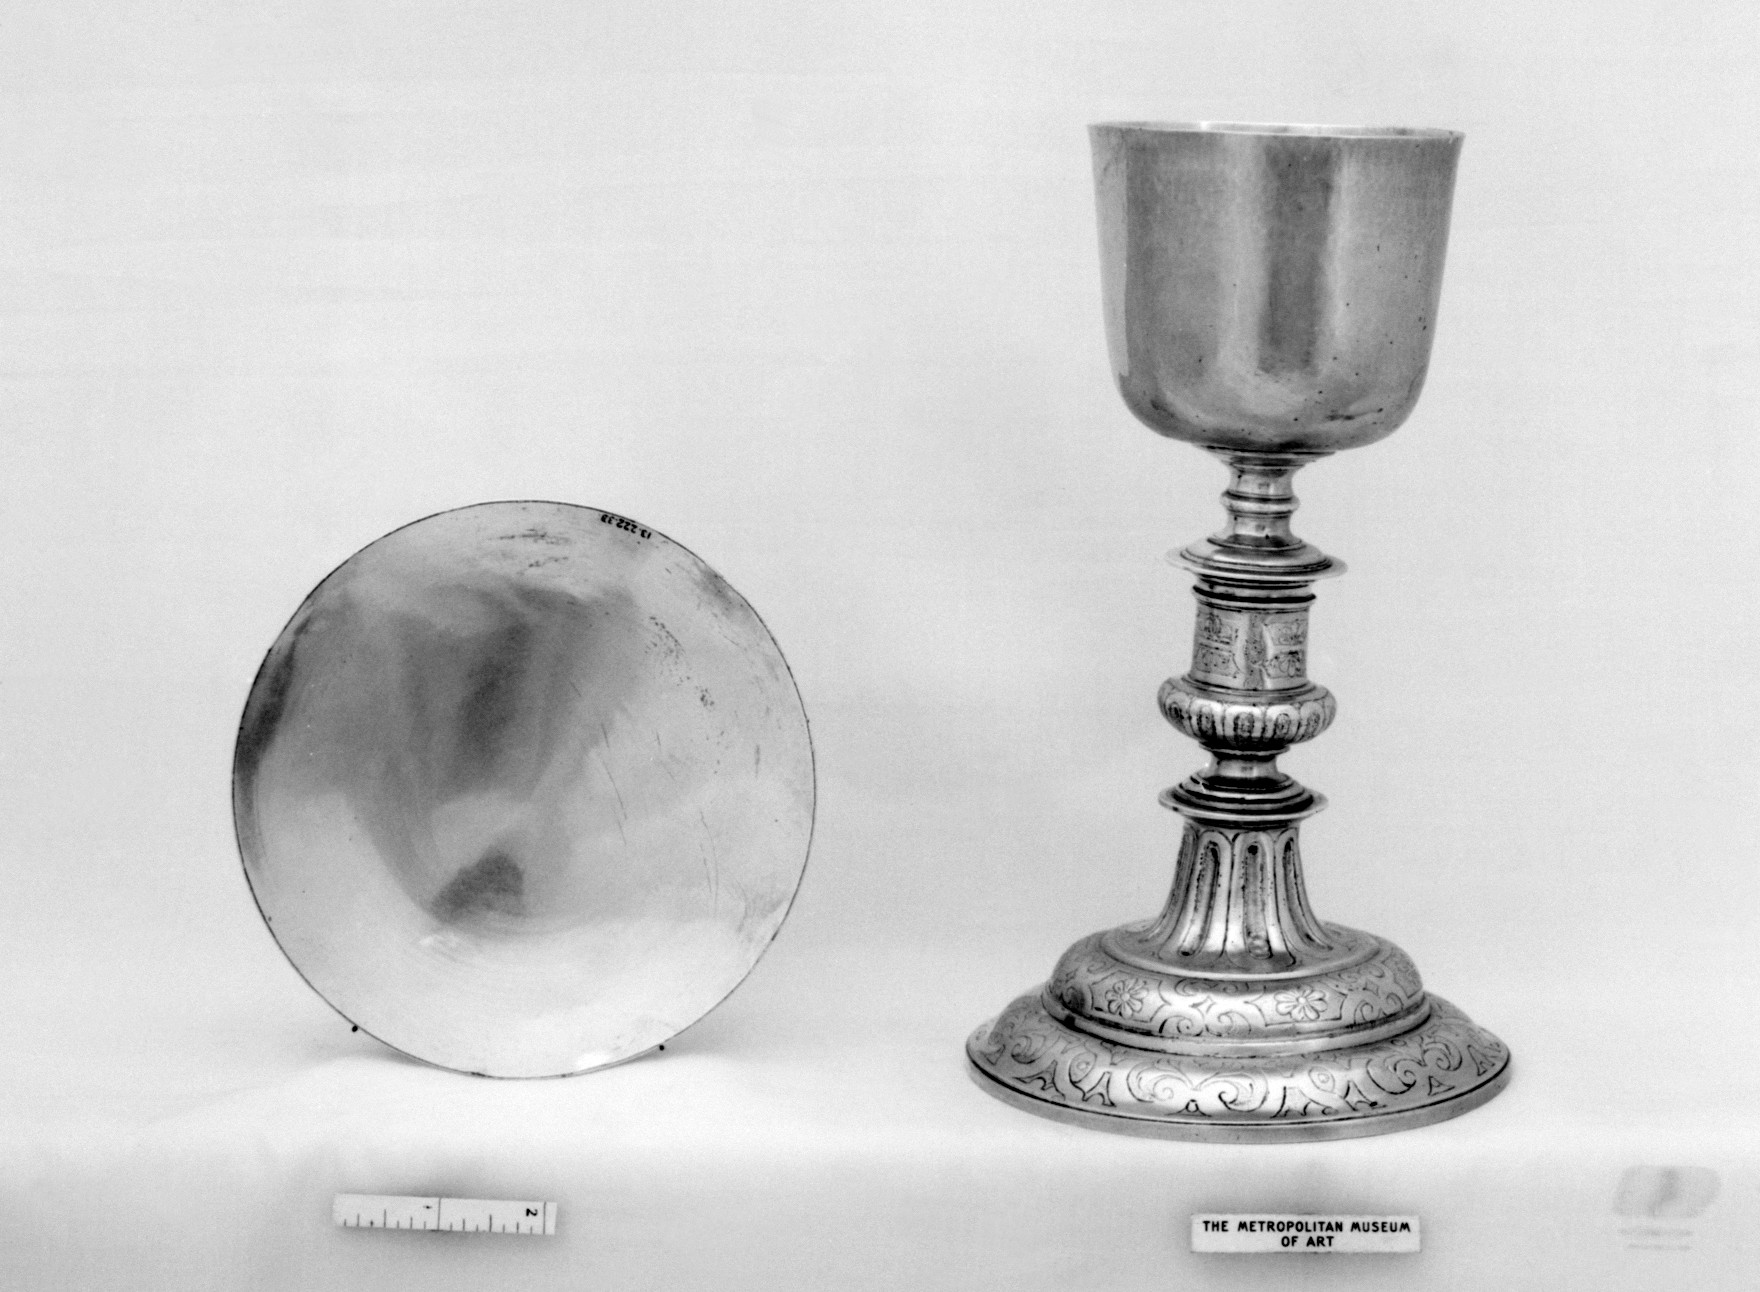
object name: chalice and paten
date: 1601-1633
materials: silver gilt